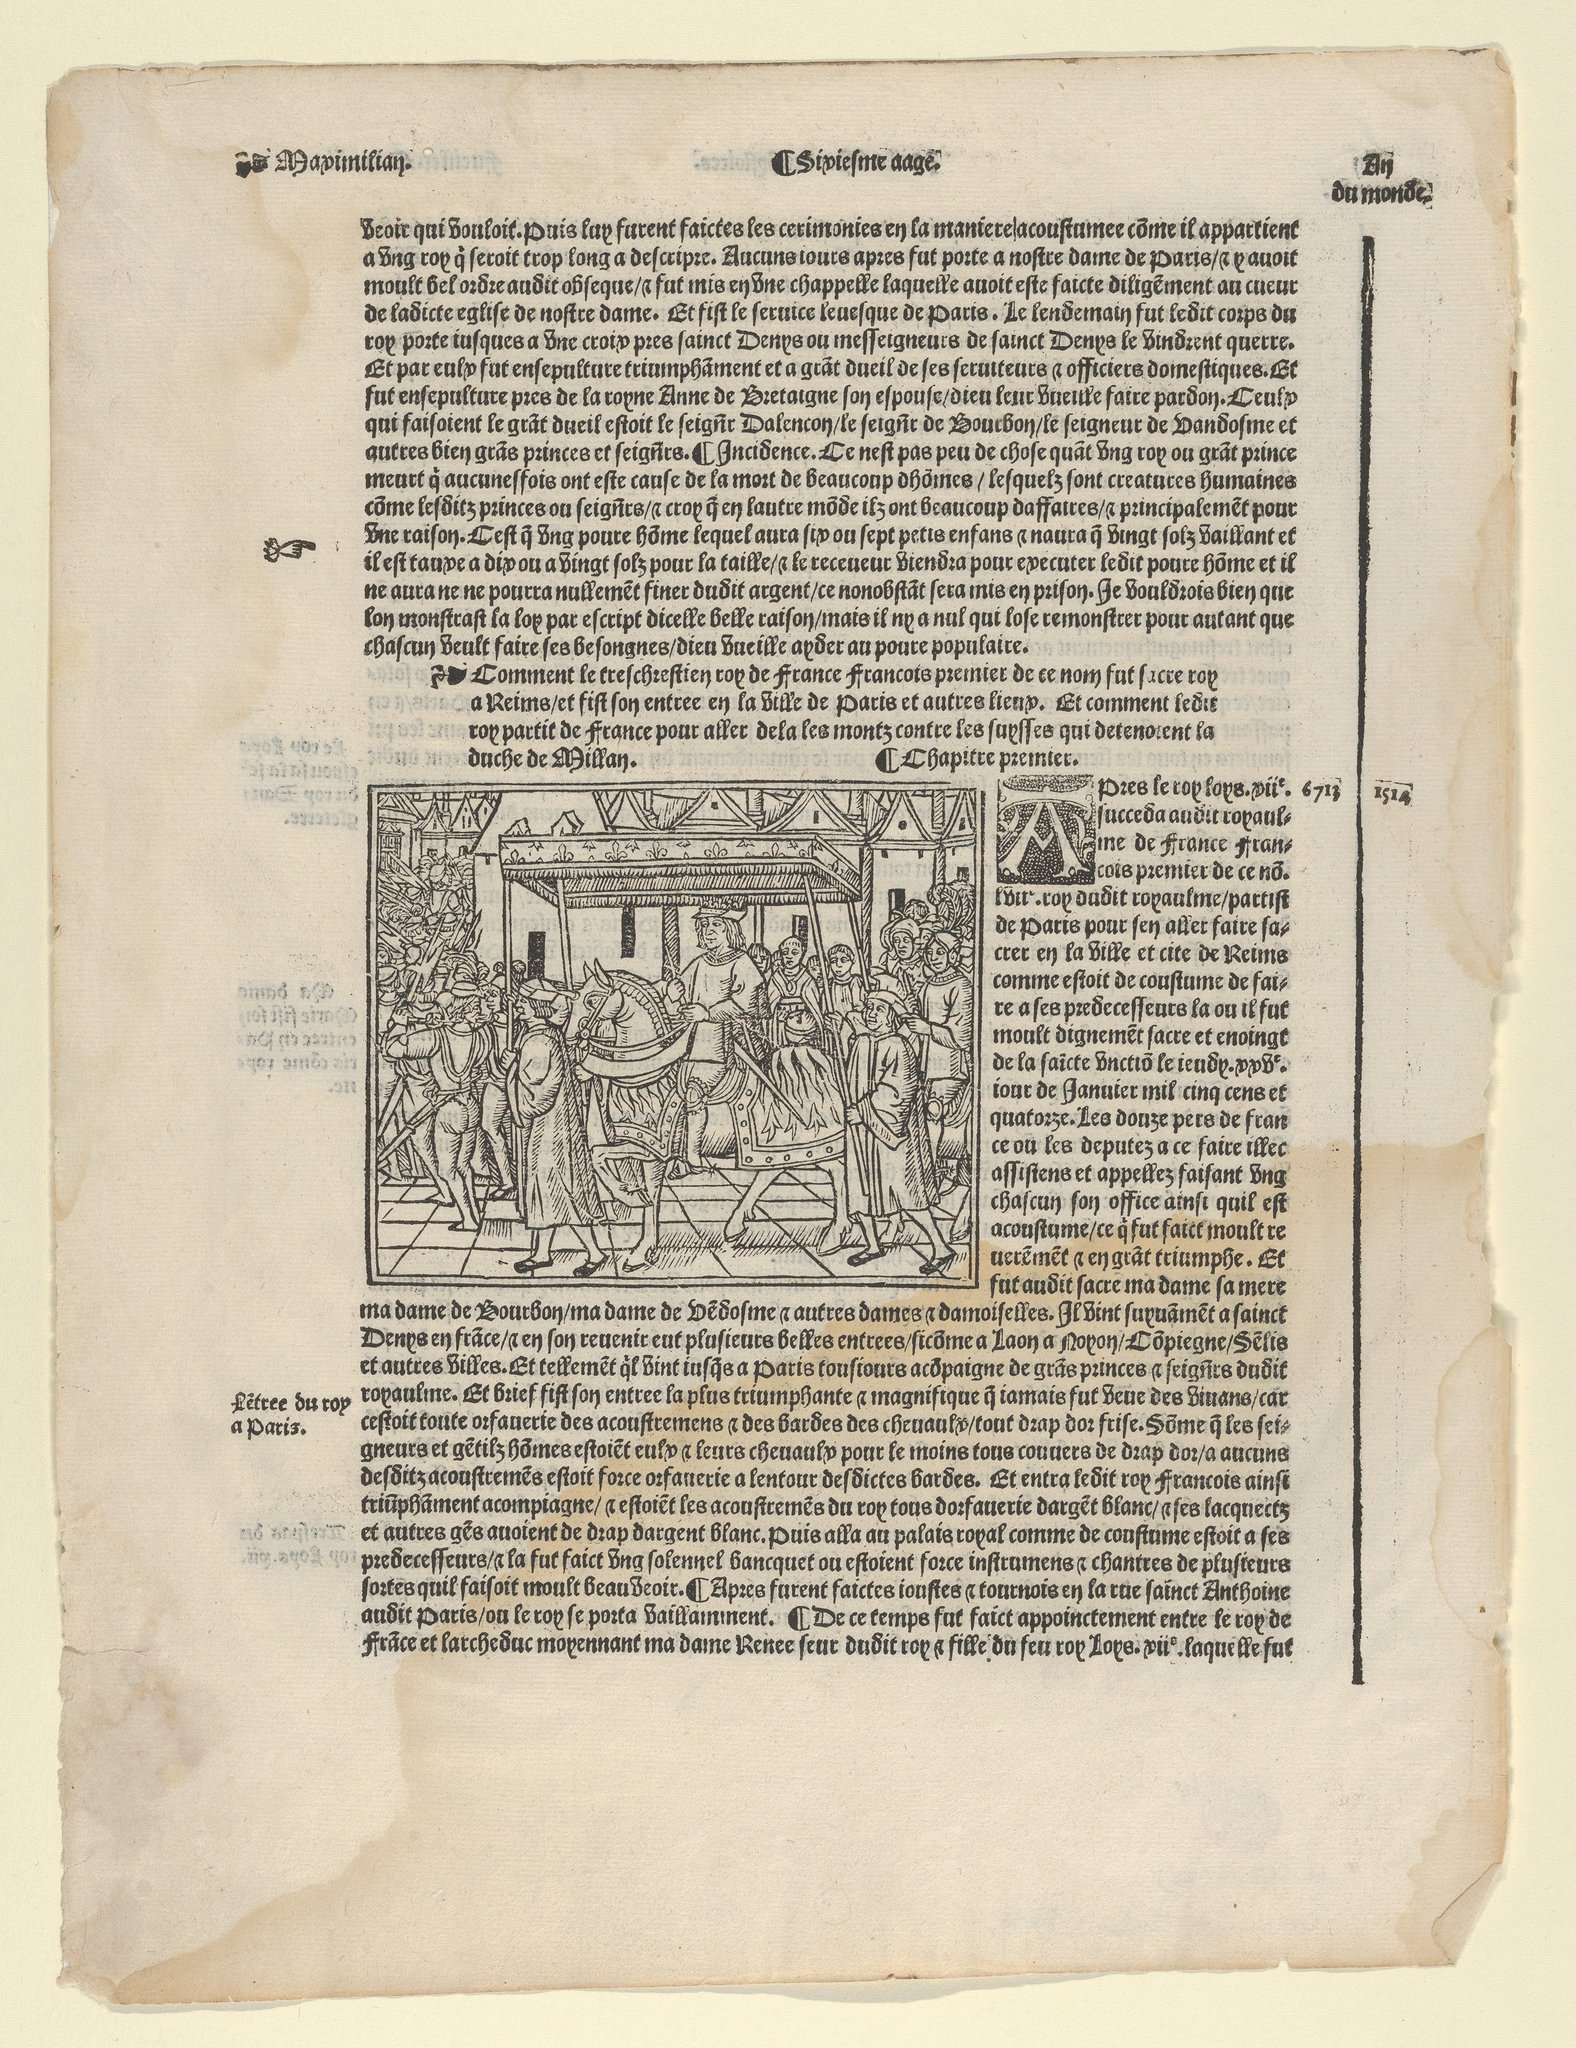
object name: print, fete, ornament architecture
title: Page from 'La Mer de Histoires'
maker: anonymous, french, 16th century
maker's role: artist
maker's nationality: french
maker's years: 1500-1600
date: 1536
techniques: woodcut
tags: men,horses